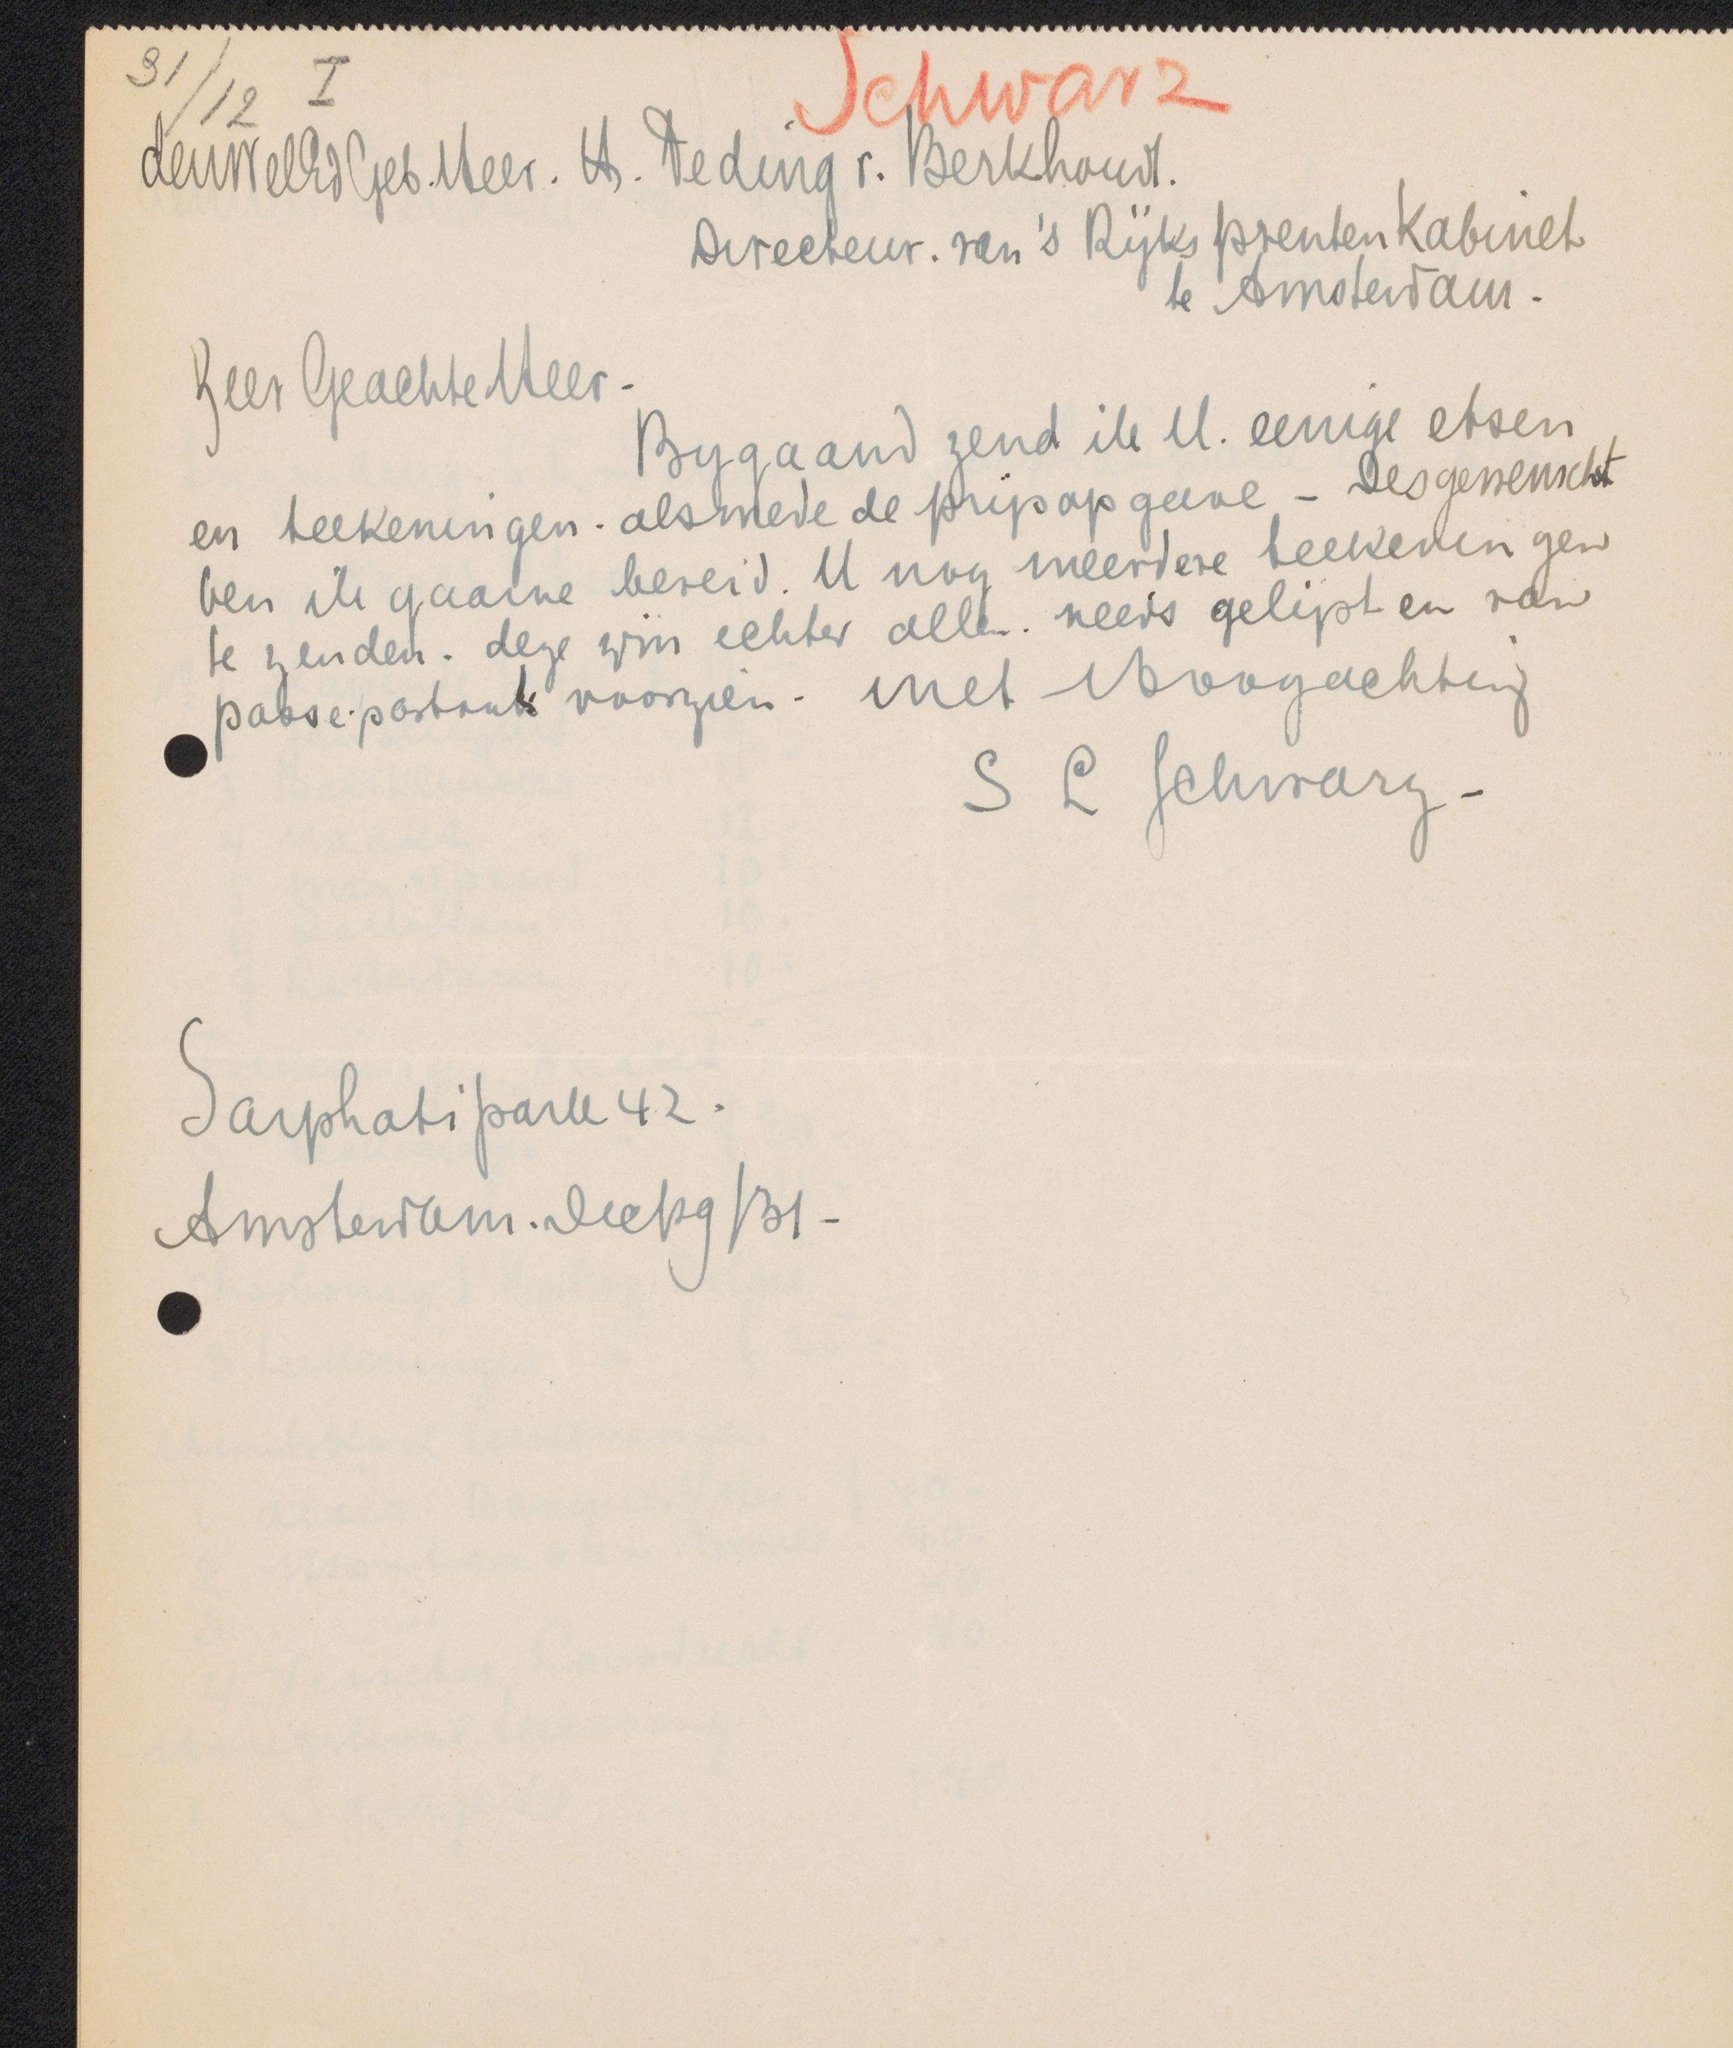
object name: letter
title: Brief aan jonkheer Hendrik Teding van Berkhout (1879-1969)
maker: mommie schwarz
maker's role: print maker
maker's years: 1876-1942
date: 1931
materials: ink, paper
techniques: pen, writing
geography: amsterdam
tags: print room, haarlem, amsterdam, jonkheer hendrik teding van berkhout (1879-1969), drawing, the graphic arts, art collecting, money